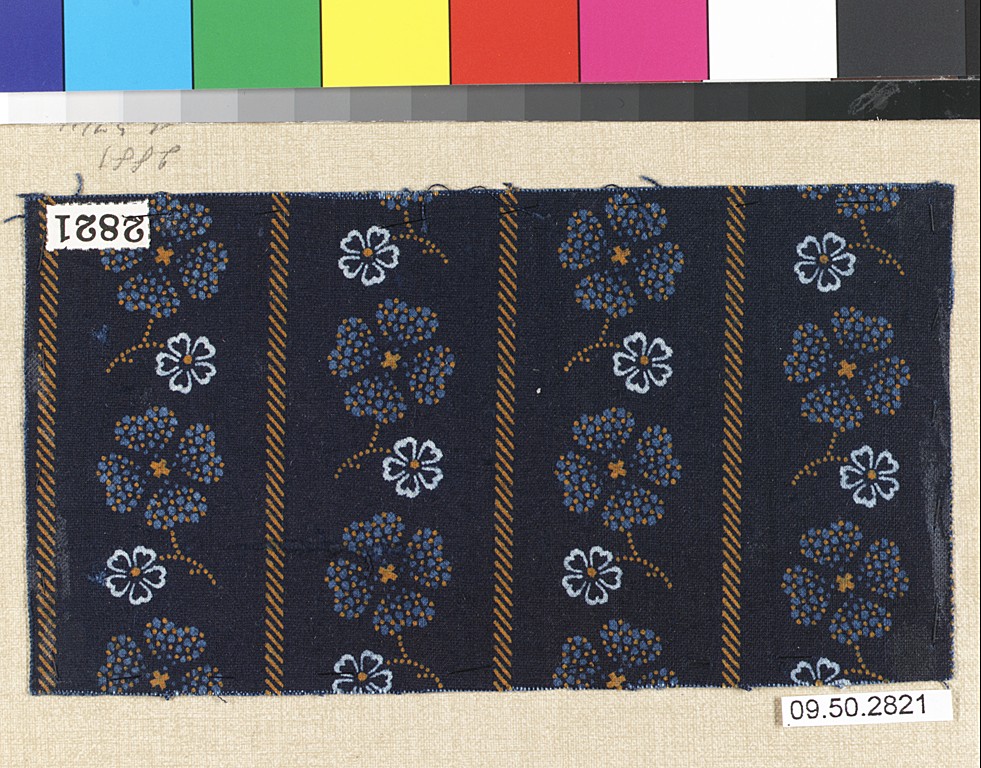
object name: piece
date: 1801-1900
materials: cotton